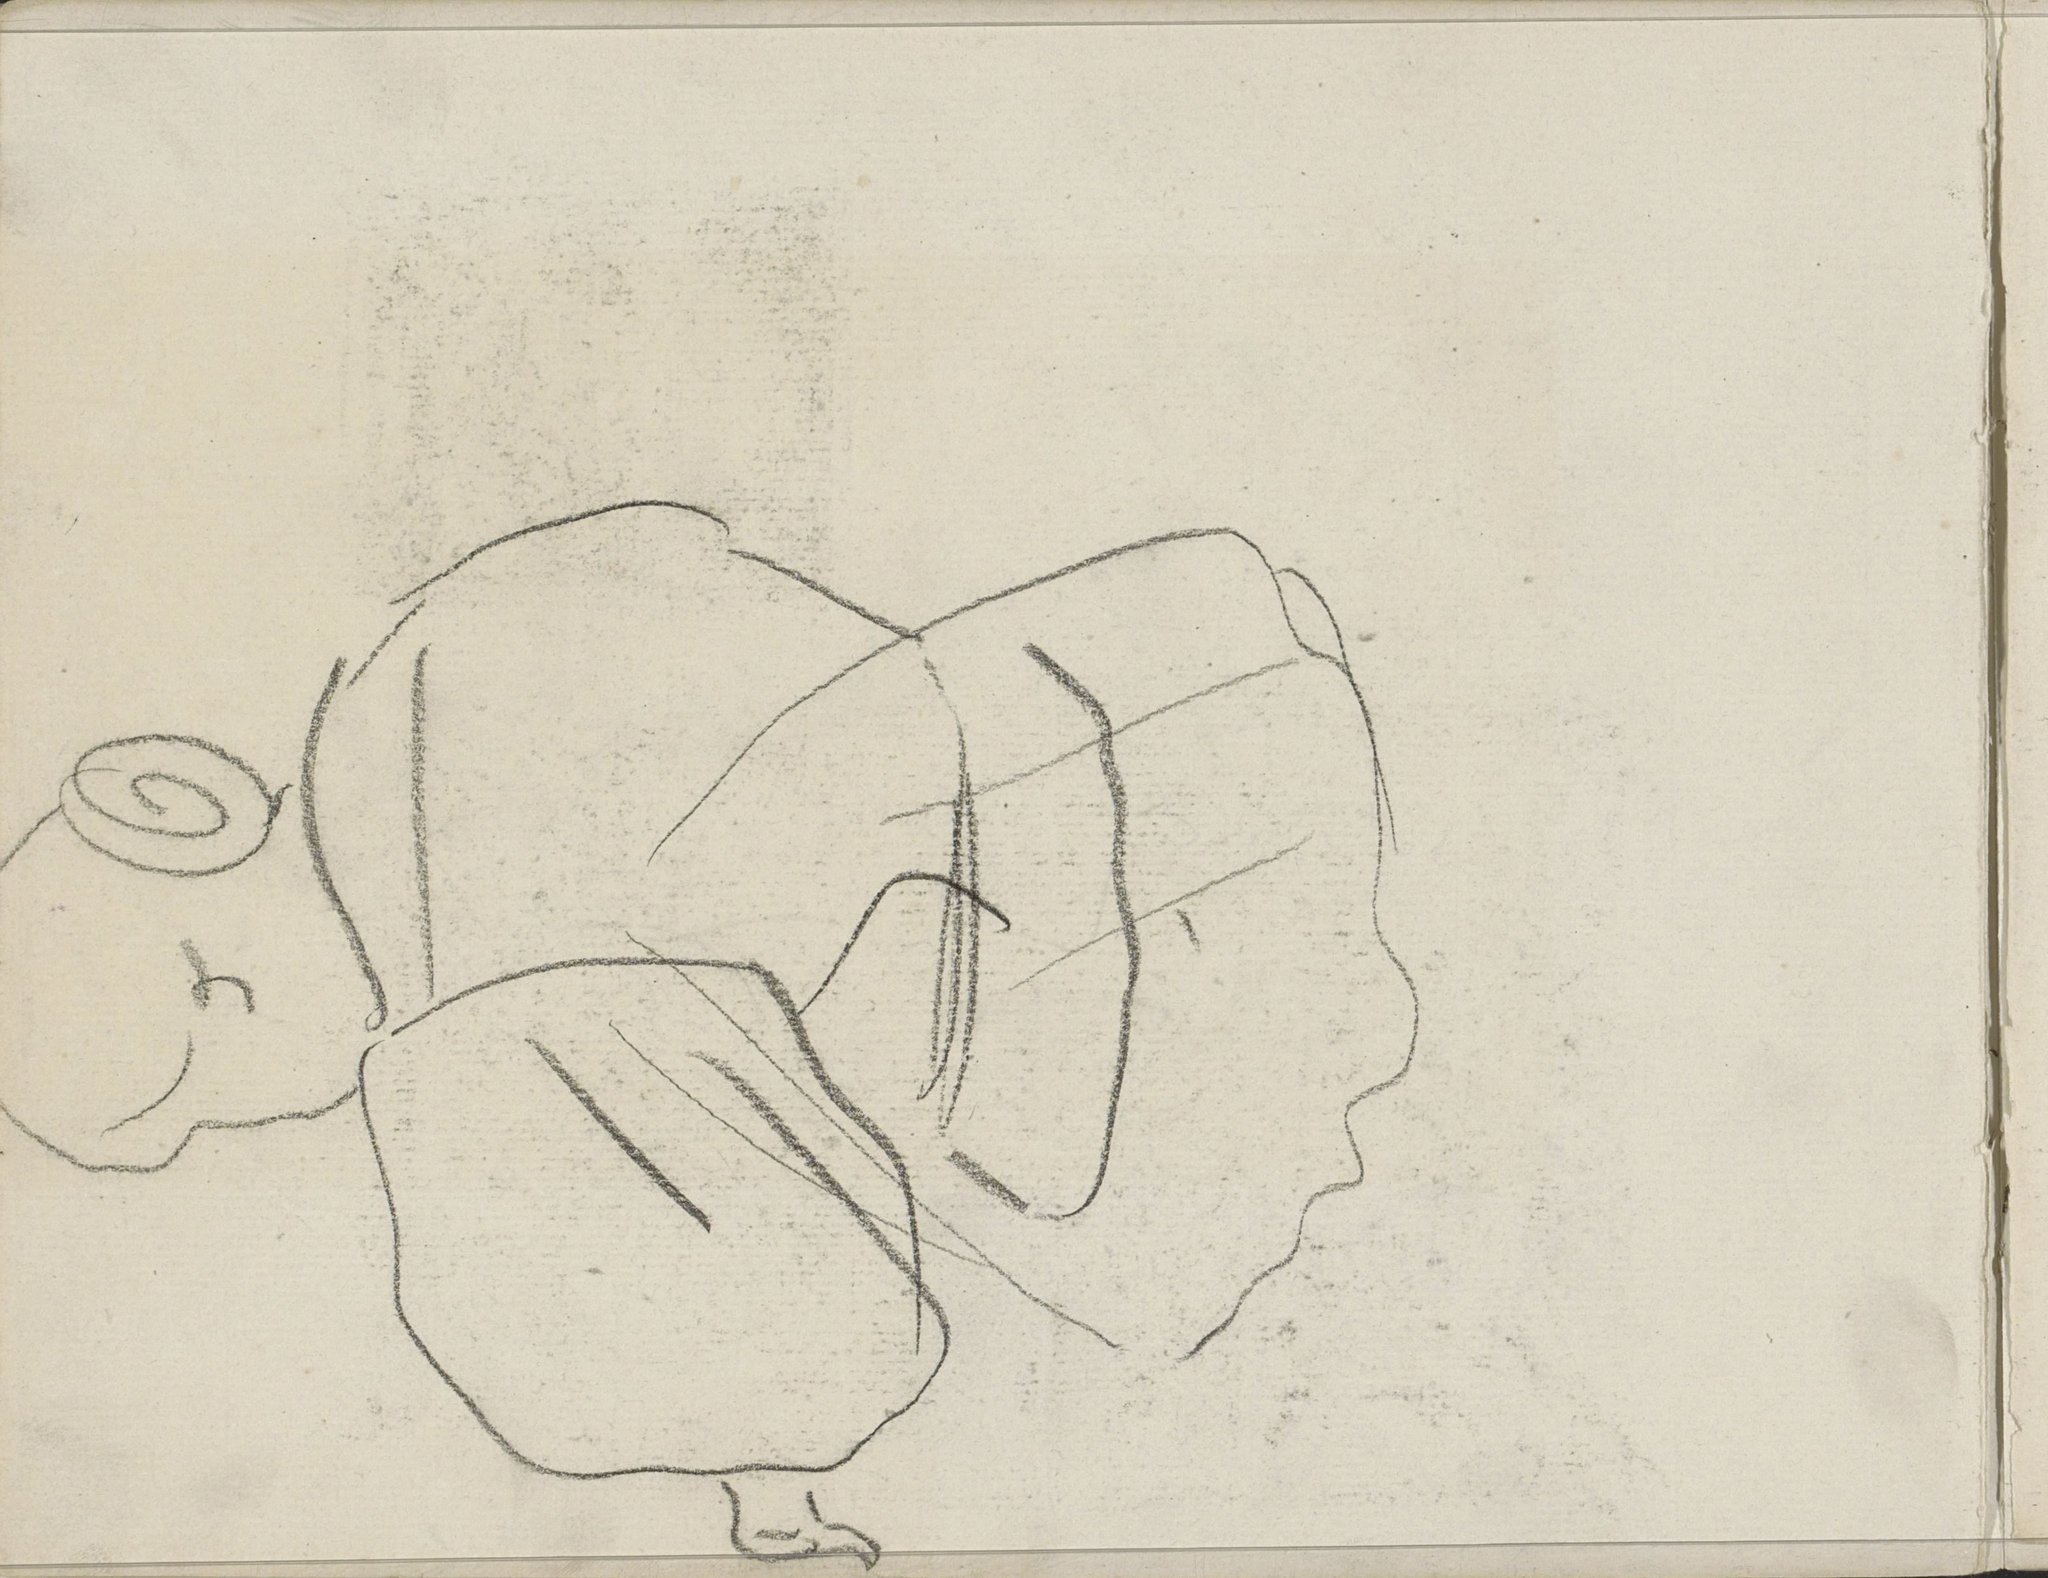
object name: sketchbook leaf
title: Zittende vrouw met een knot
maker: carel adolph lion cachet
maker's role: draughtsman, print maker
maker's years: 1864-1945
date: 1896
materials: chalk, paper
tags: sitting figure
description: Blad 16 verso uit een schetsboek met 44 bladen.